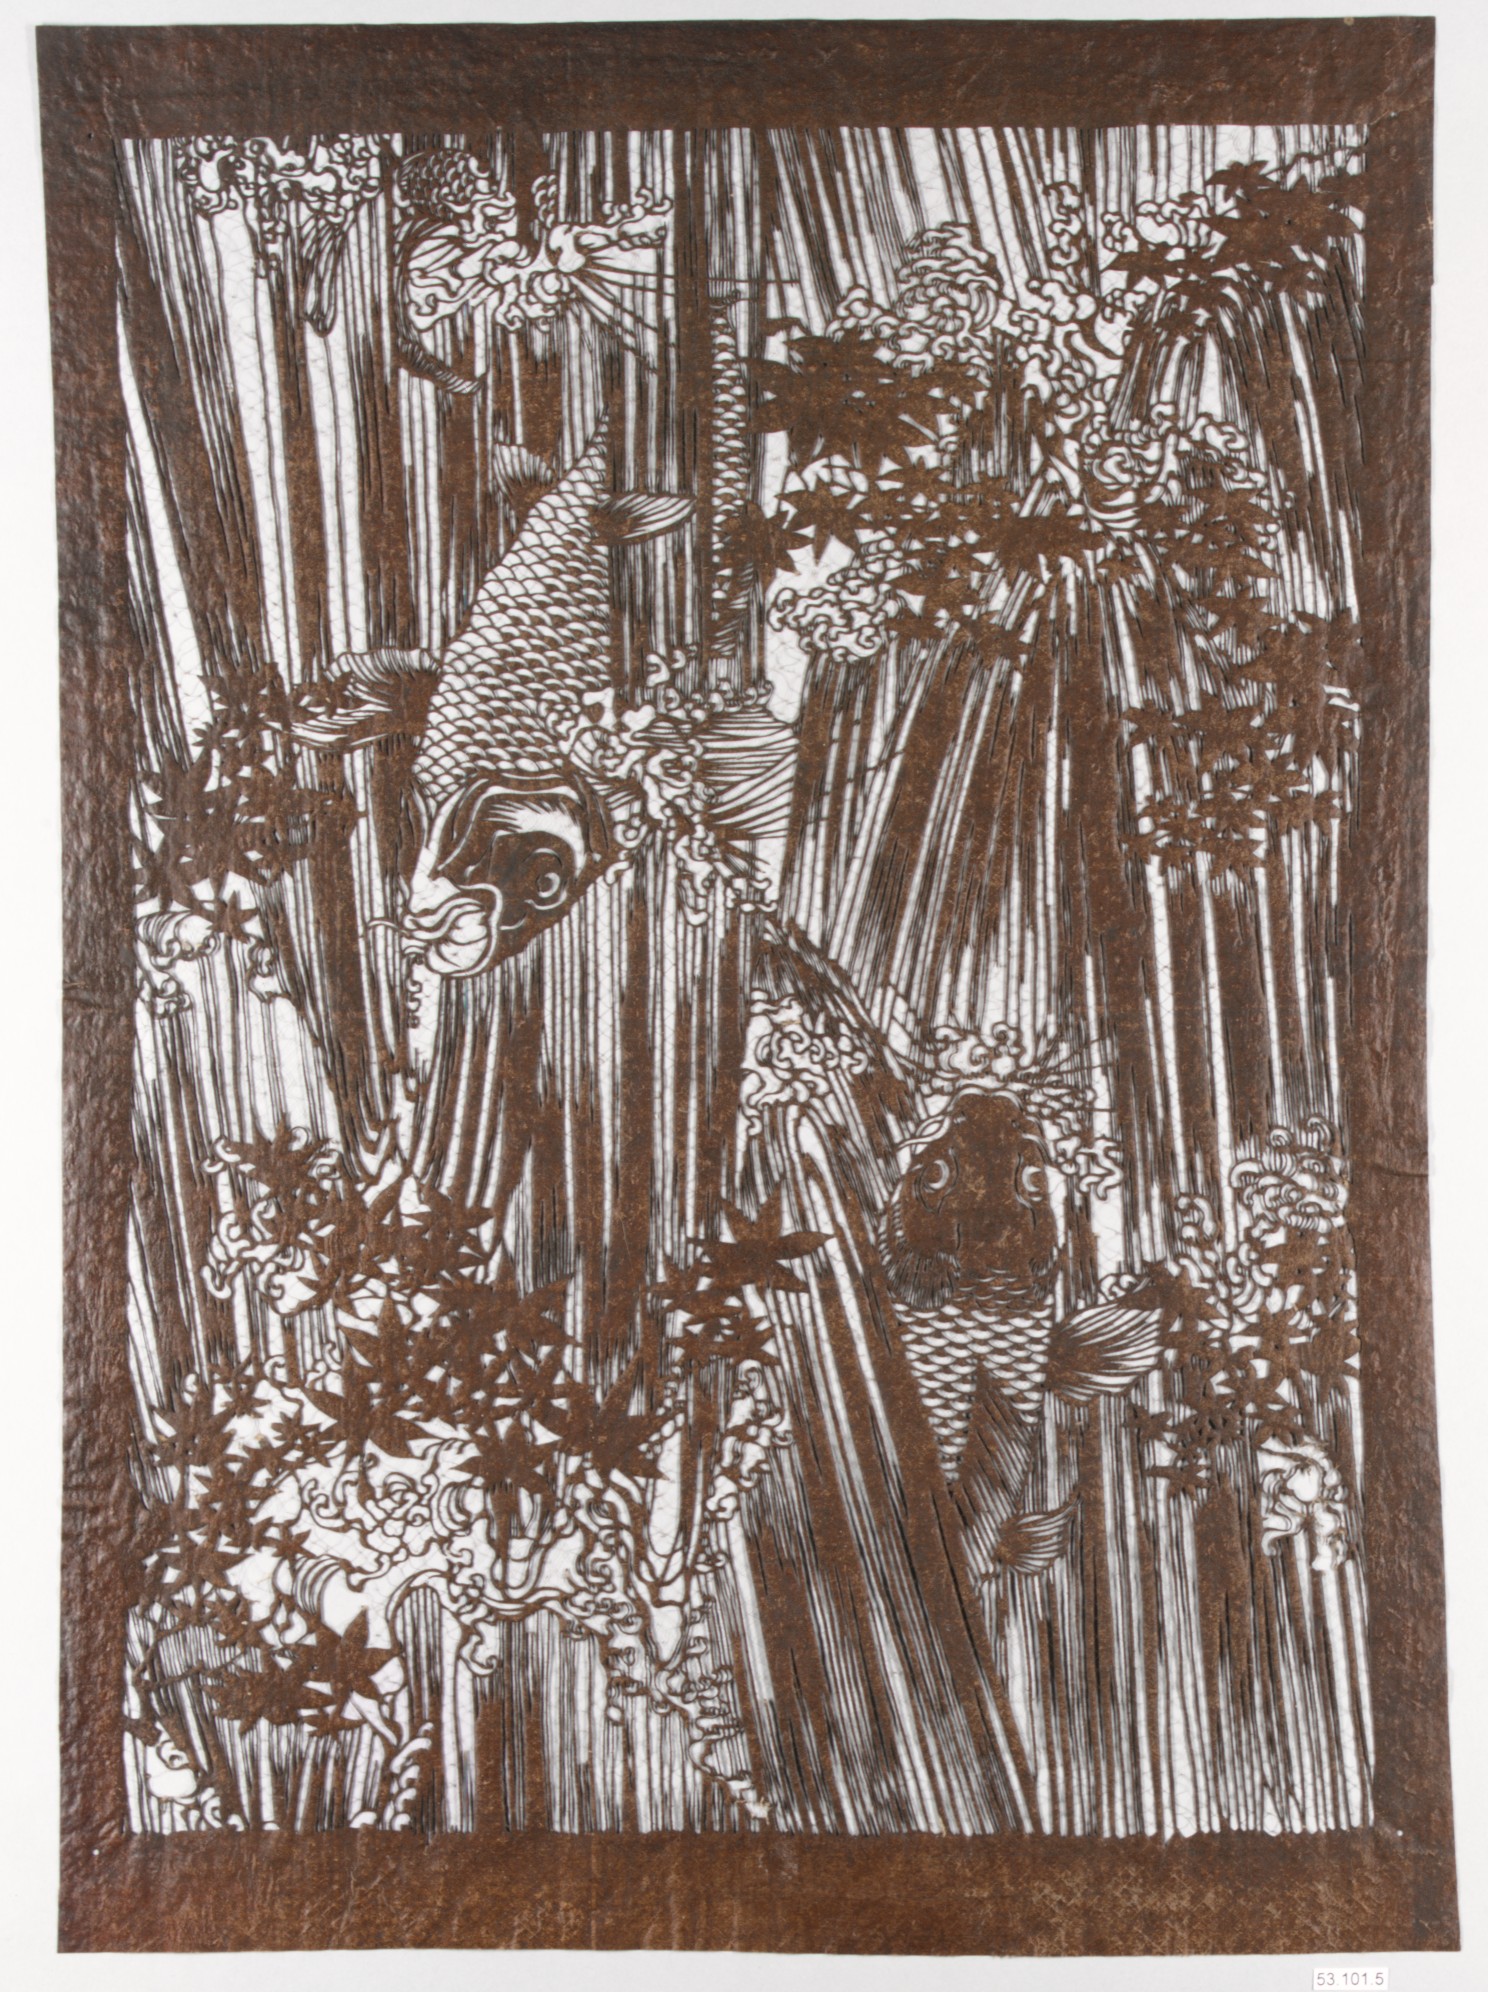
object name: stencil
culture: japanese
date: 1615-1868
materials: paper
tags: fish